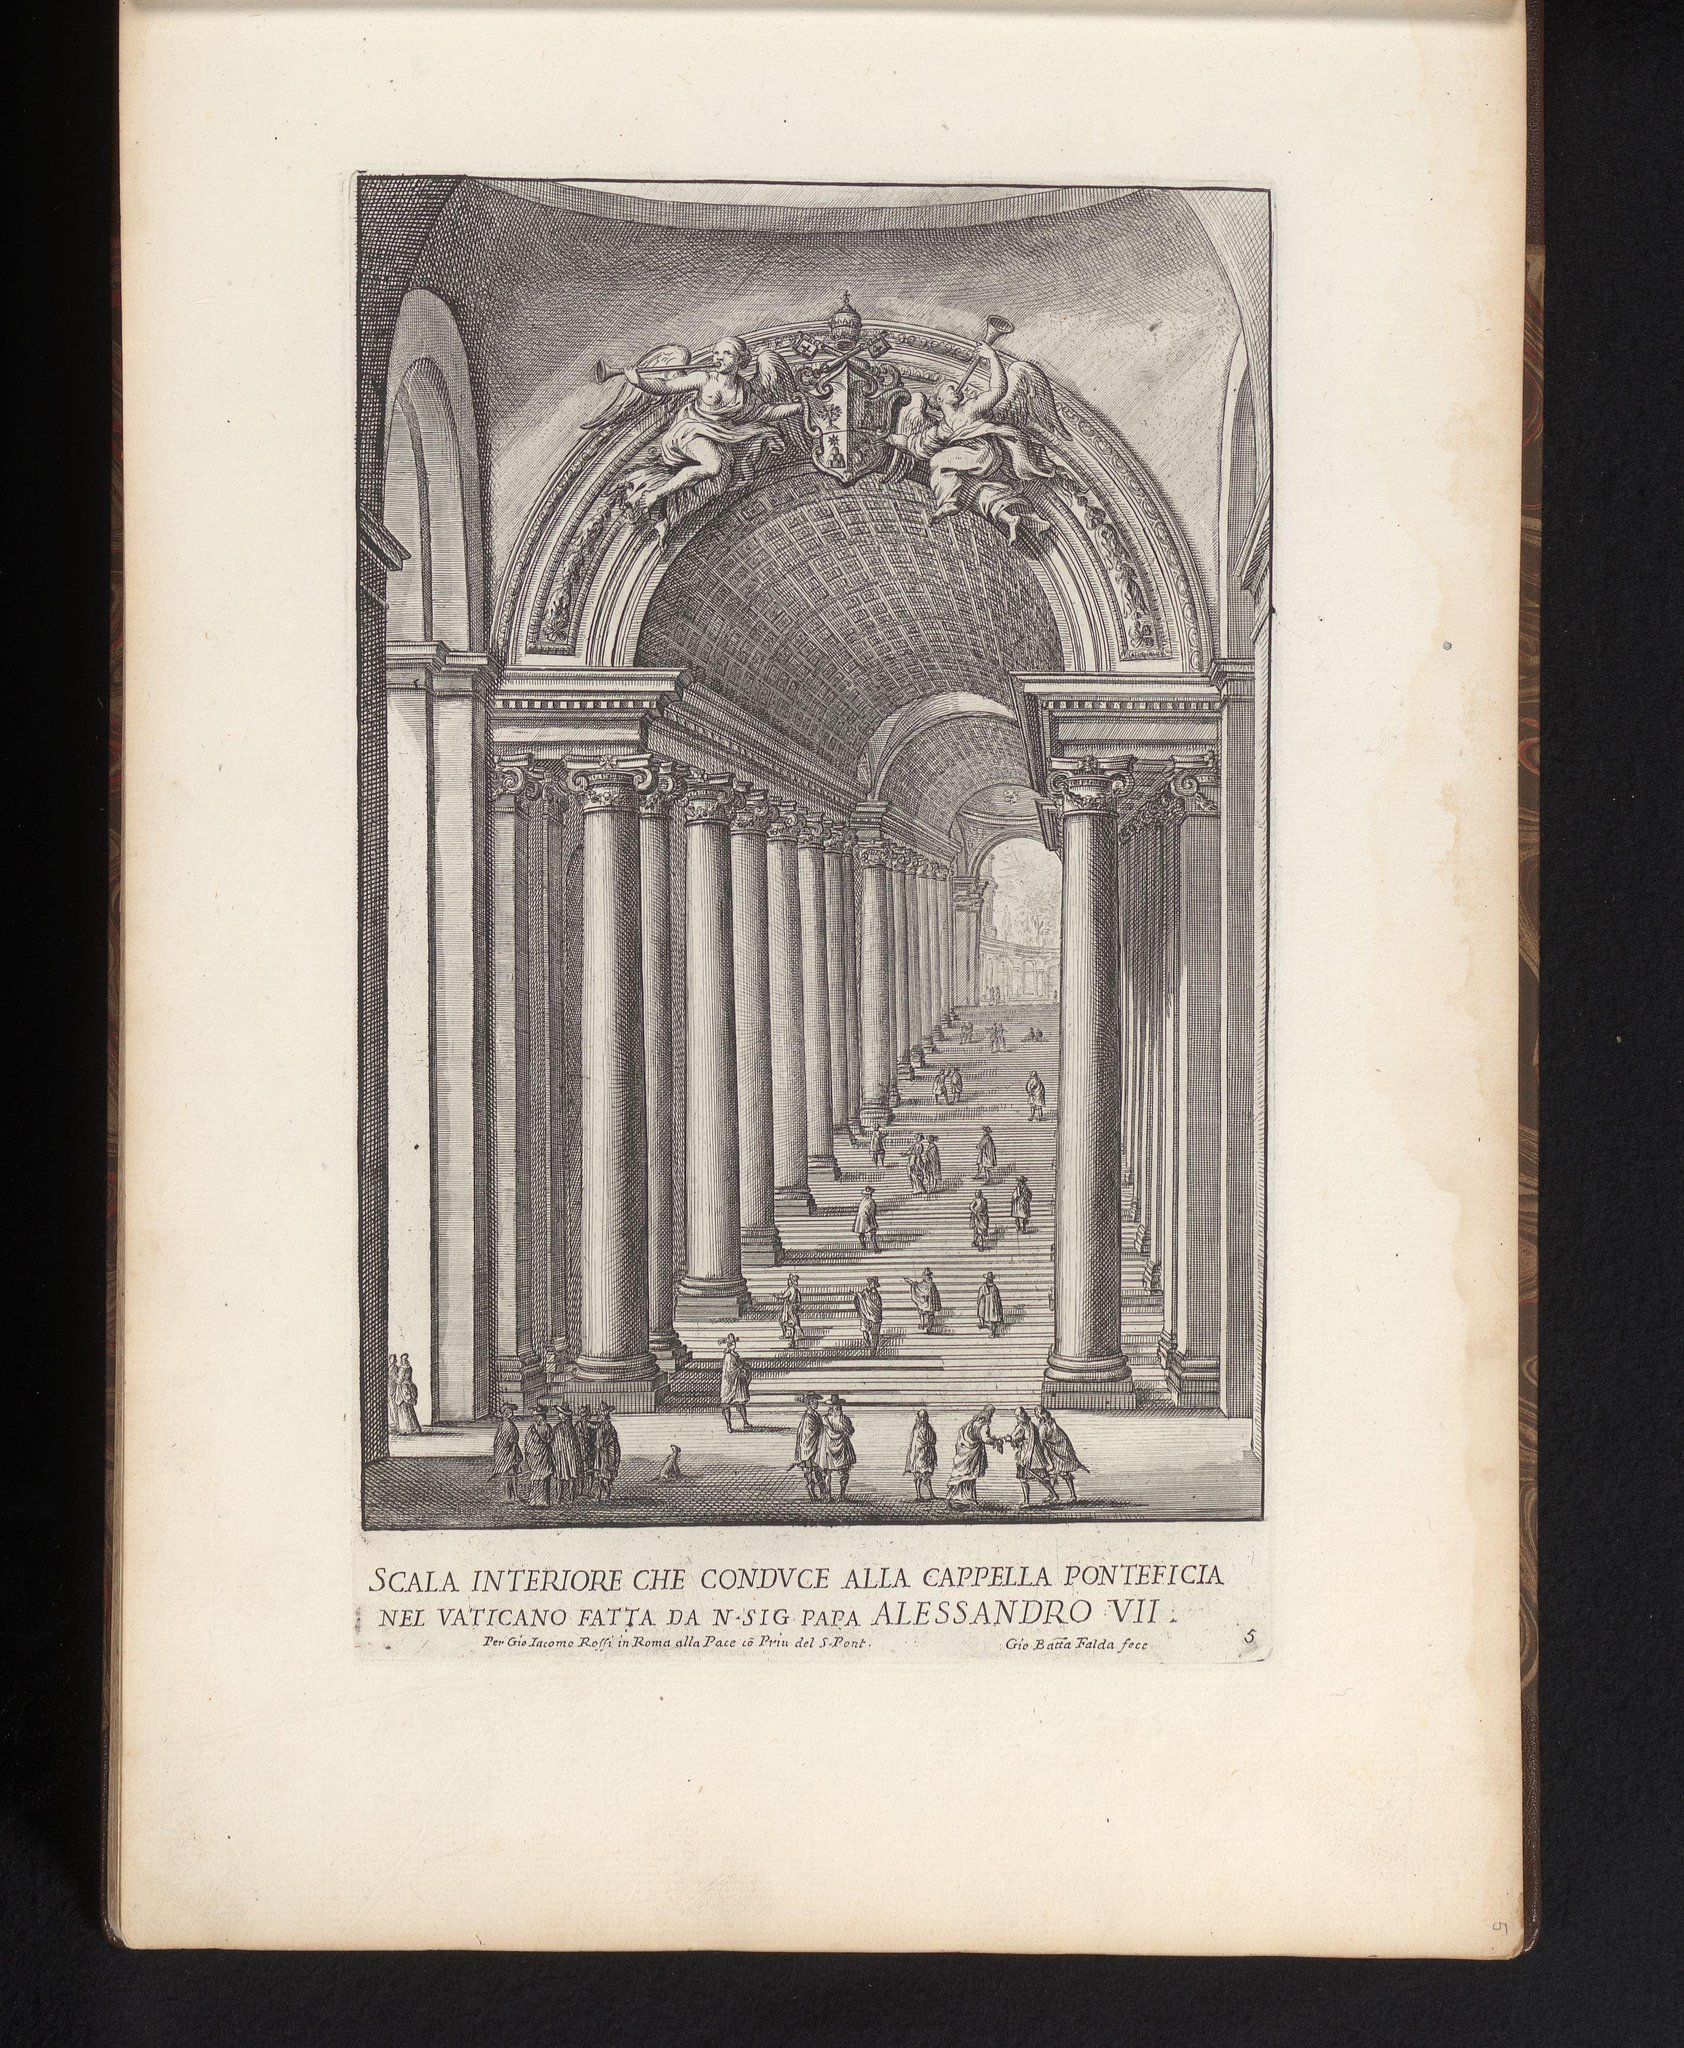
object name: album leaf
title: Il nuovo teatro delle fabriche, et edificii, in prospettiva di Rome Modern (...) (libro primo)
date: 1665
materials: paper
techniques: etching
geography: rome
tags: staircase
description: Deze prent maakt deel uit van een reeks van 35 prenten met voorstellingen van gebouwen in Rome. Samen met vier andere reeksen vormt het de grote reeks: 'Il nuovo teatro di Roma moderna'.